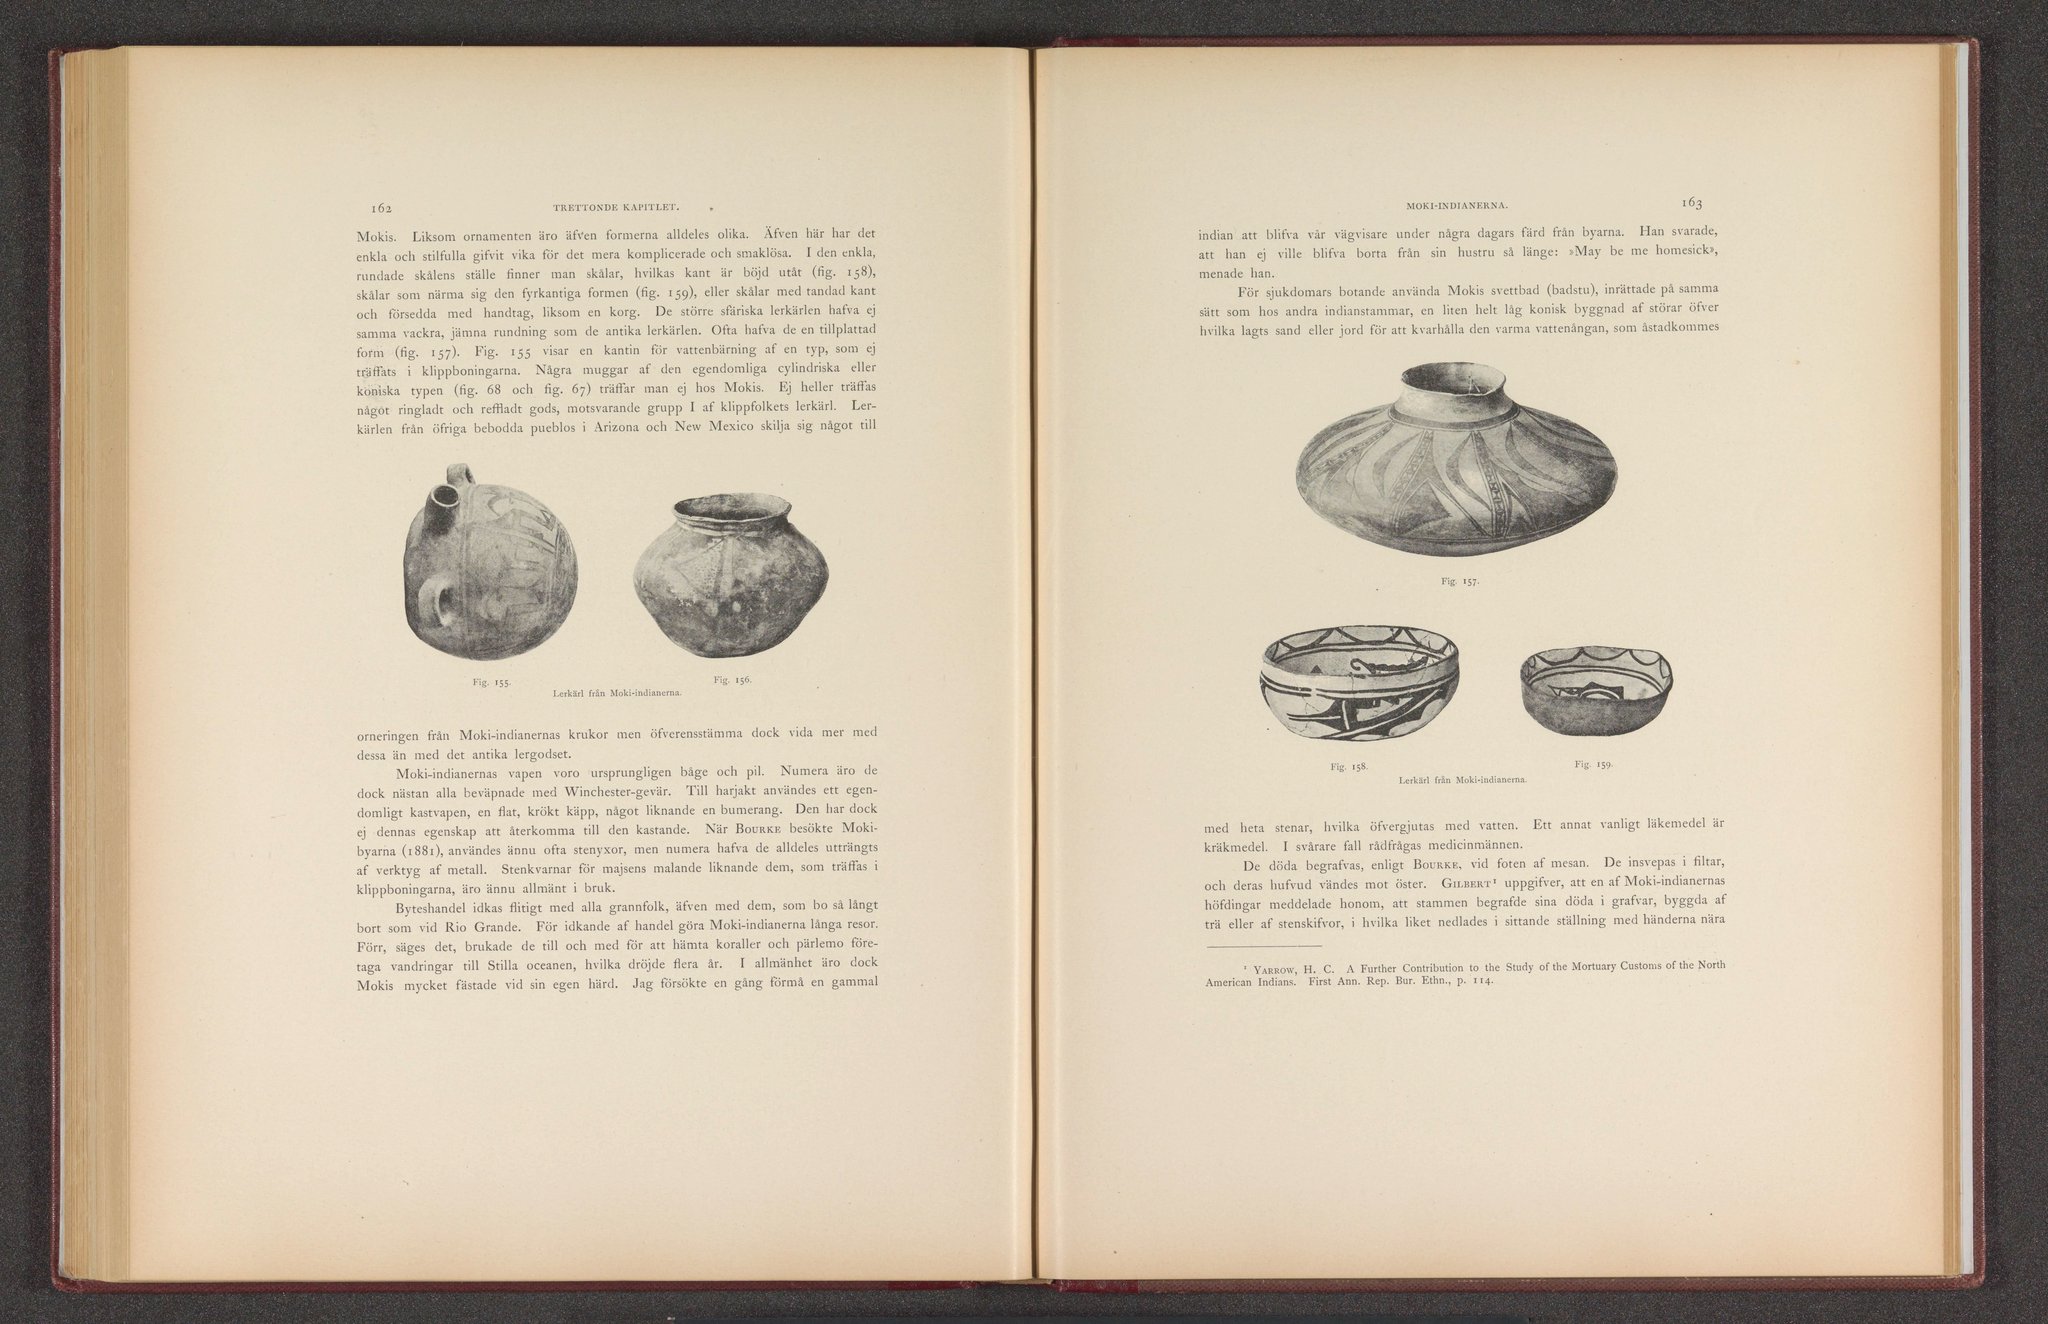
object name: photomechanical print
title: Lekärl från Moki-indianerna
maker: gustaf nordenskiöld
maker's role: fotograaf, schrijver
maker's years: 1868-1895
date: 1891-1893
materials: paper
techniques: autotype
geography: vienna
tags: container of ceramics: jar, jug, pot, vase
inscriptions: number: ‘Fig. 155. Fig. 156.’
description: Twee aardewerken potten van het Hopi-volk uit Arizona.